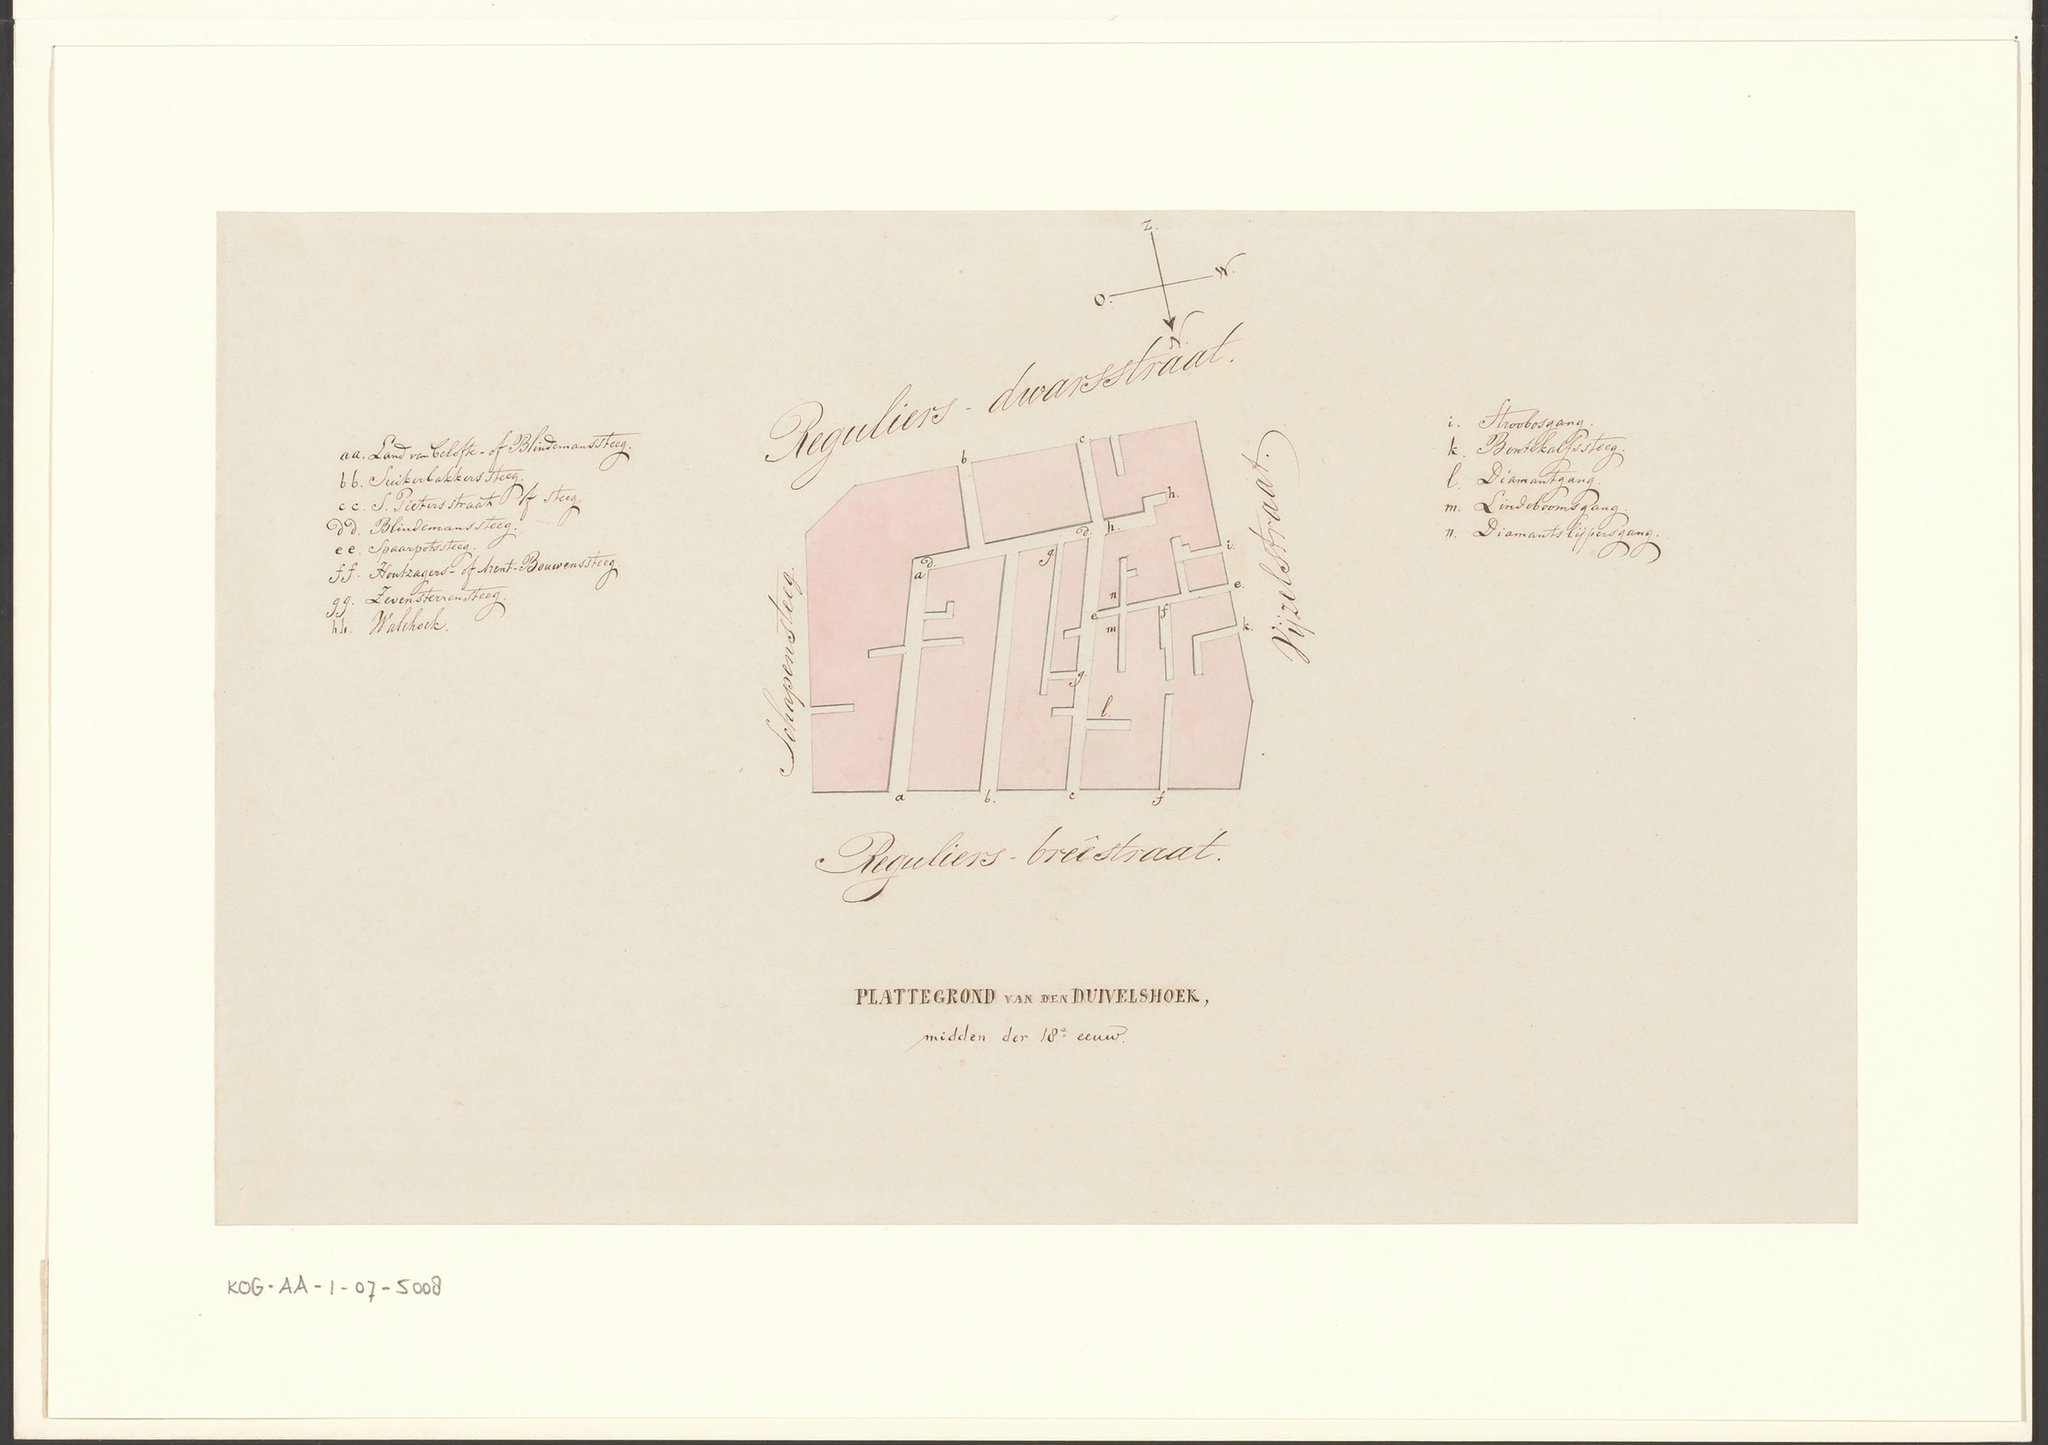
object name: drawing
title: Plattegrond van de Duvelshoek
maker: Anonymous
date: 1700-1775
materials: ink, paper, pencil, watercolor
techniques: brush, pen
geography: amsterdam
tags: city-view in general; 'veduta', maps of cities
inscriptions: collector's mark: ‘07’ Lugt 1641b, inscription: ‘Port. 7’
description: Onderwerpsrubriek binnen de Atlas Amsterdam: Damrak, Damstraat, Doelensluis, Doelenstraat (Nieuwe), Driehoekstraat, Droogbak, Duvelshoek, Dijkstraat en Korte -.